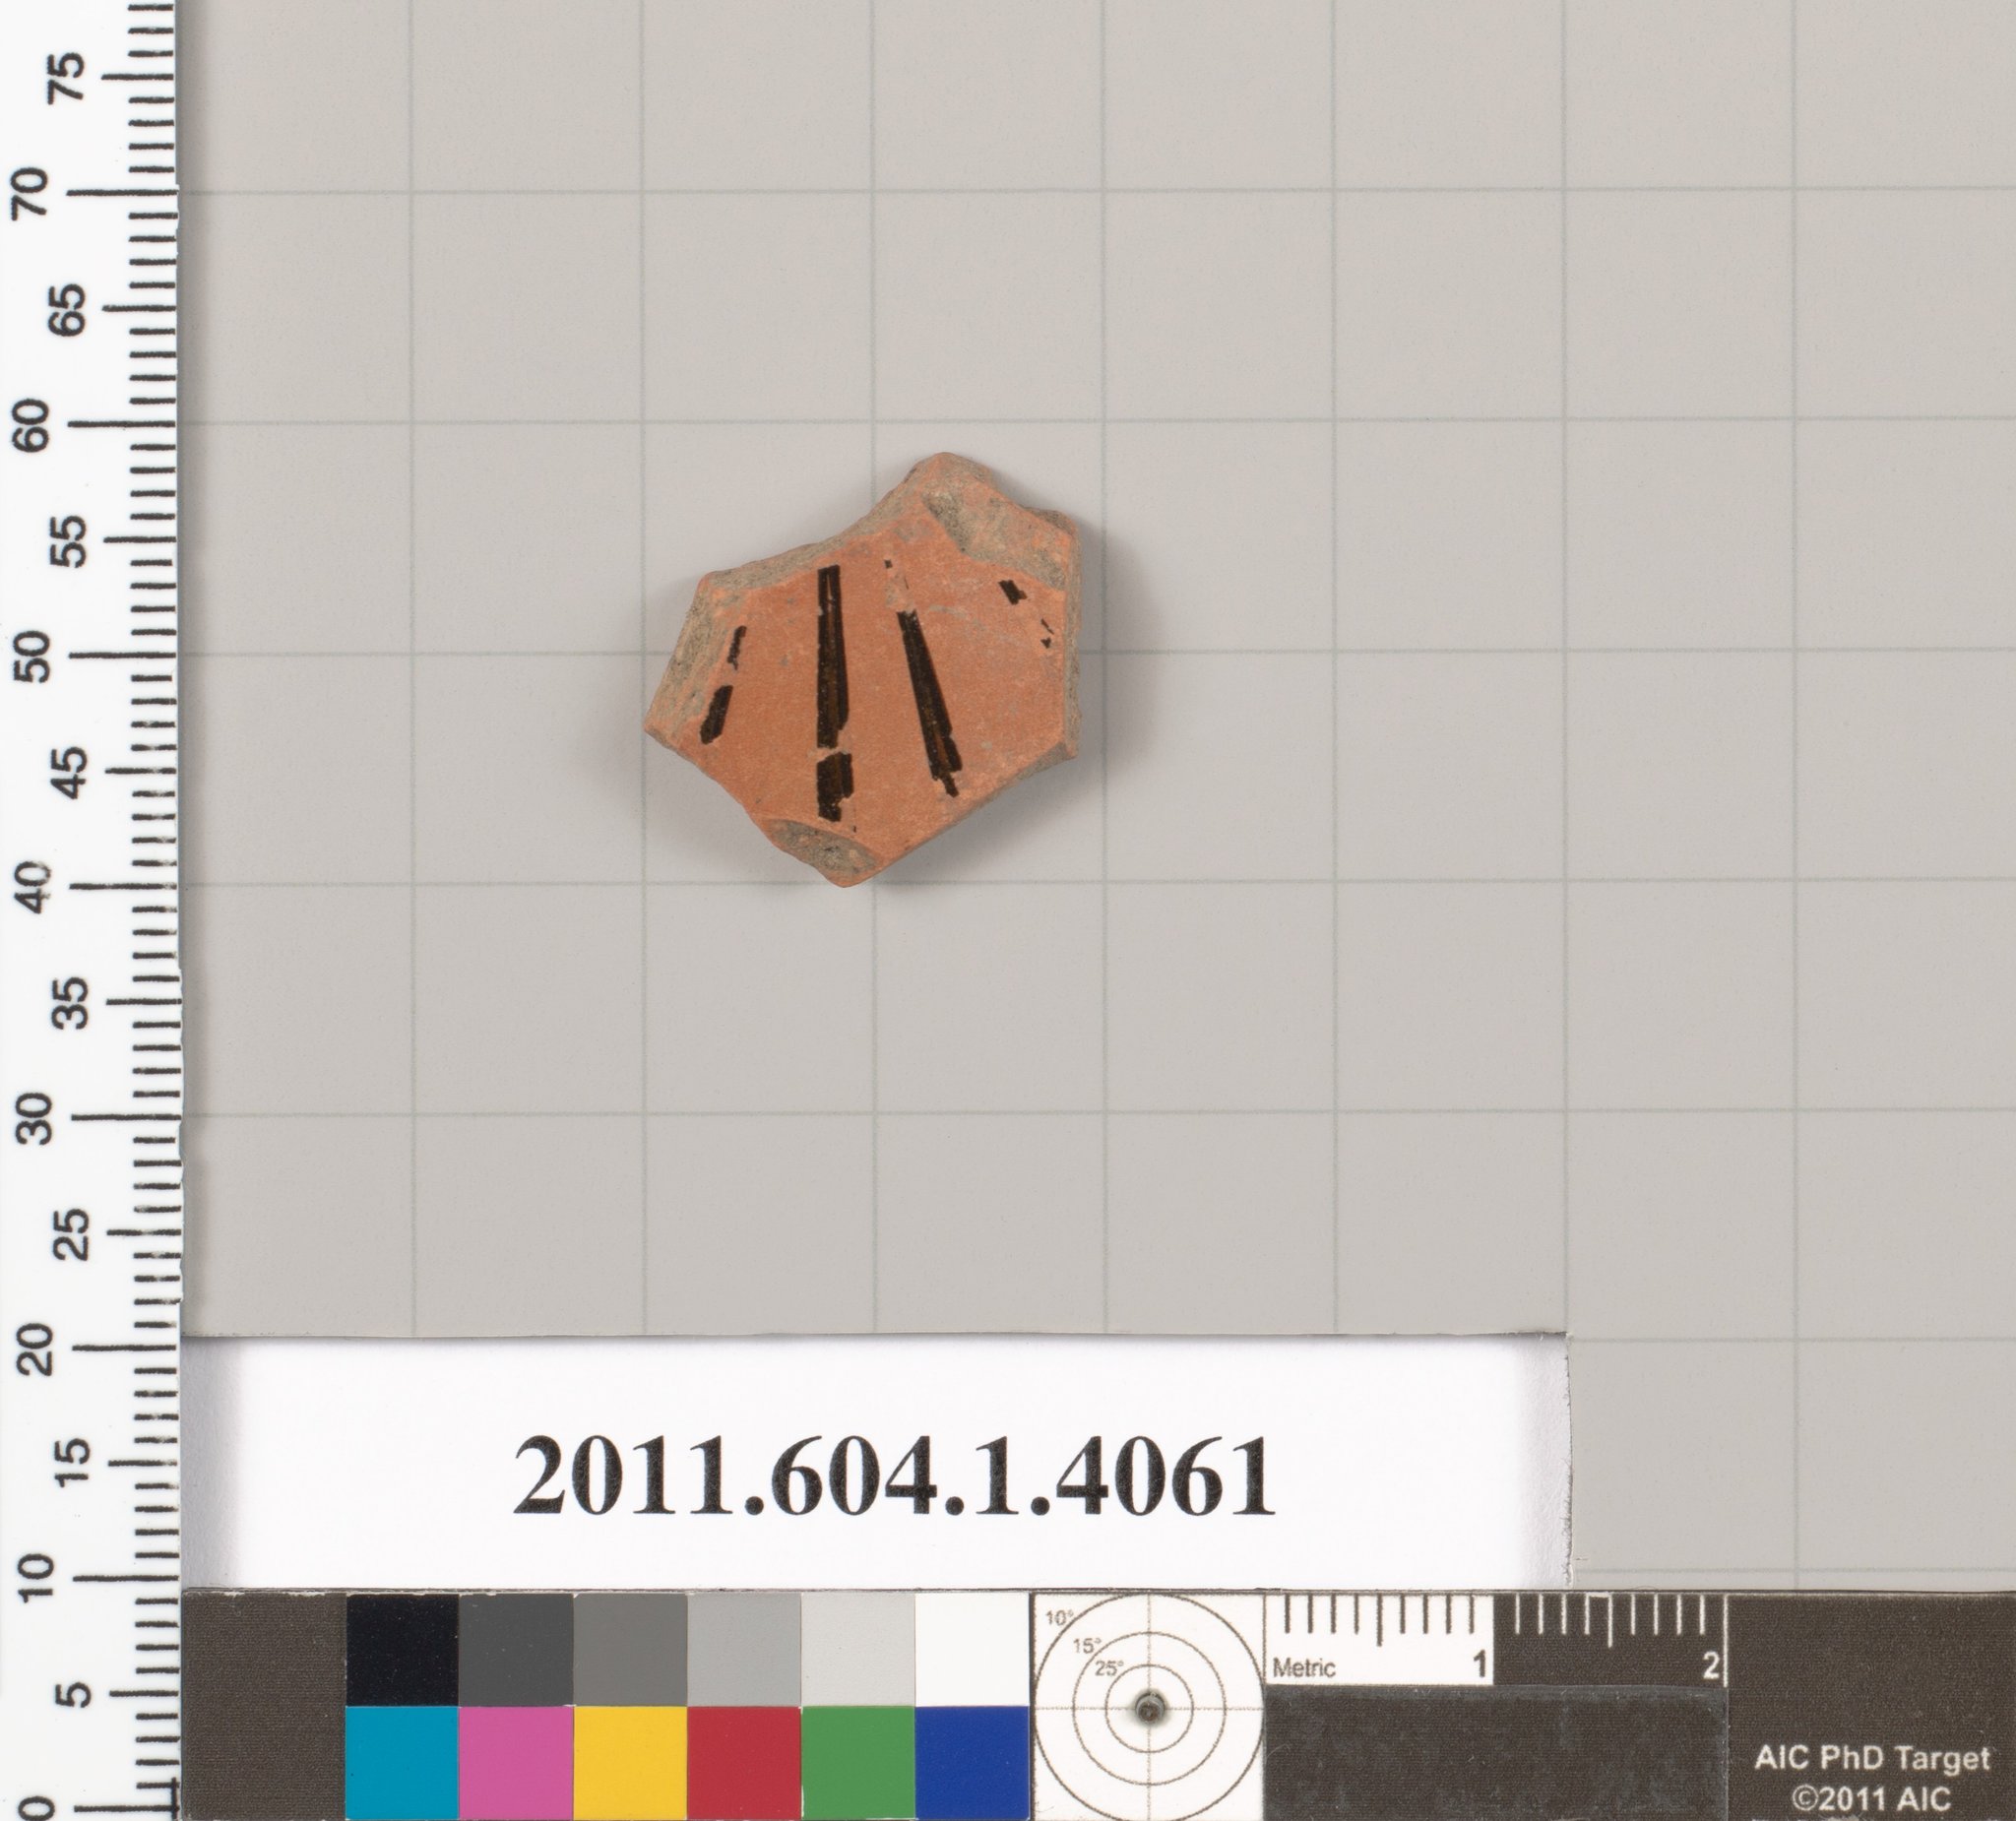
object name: kylix fragment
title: Terracotta fragment of a kylix (drinking cup)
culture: greek, attic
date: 534-468 BCE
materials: terracotta